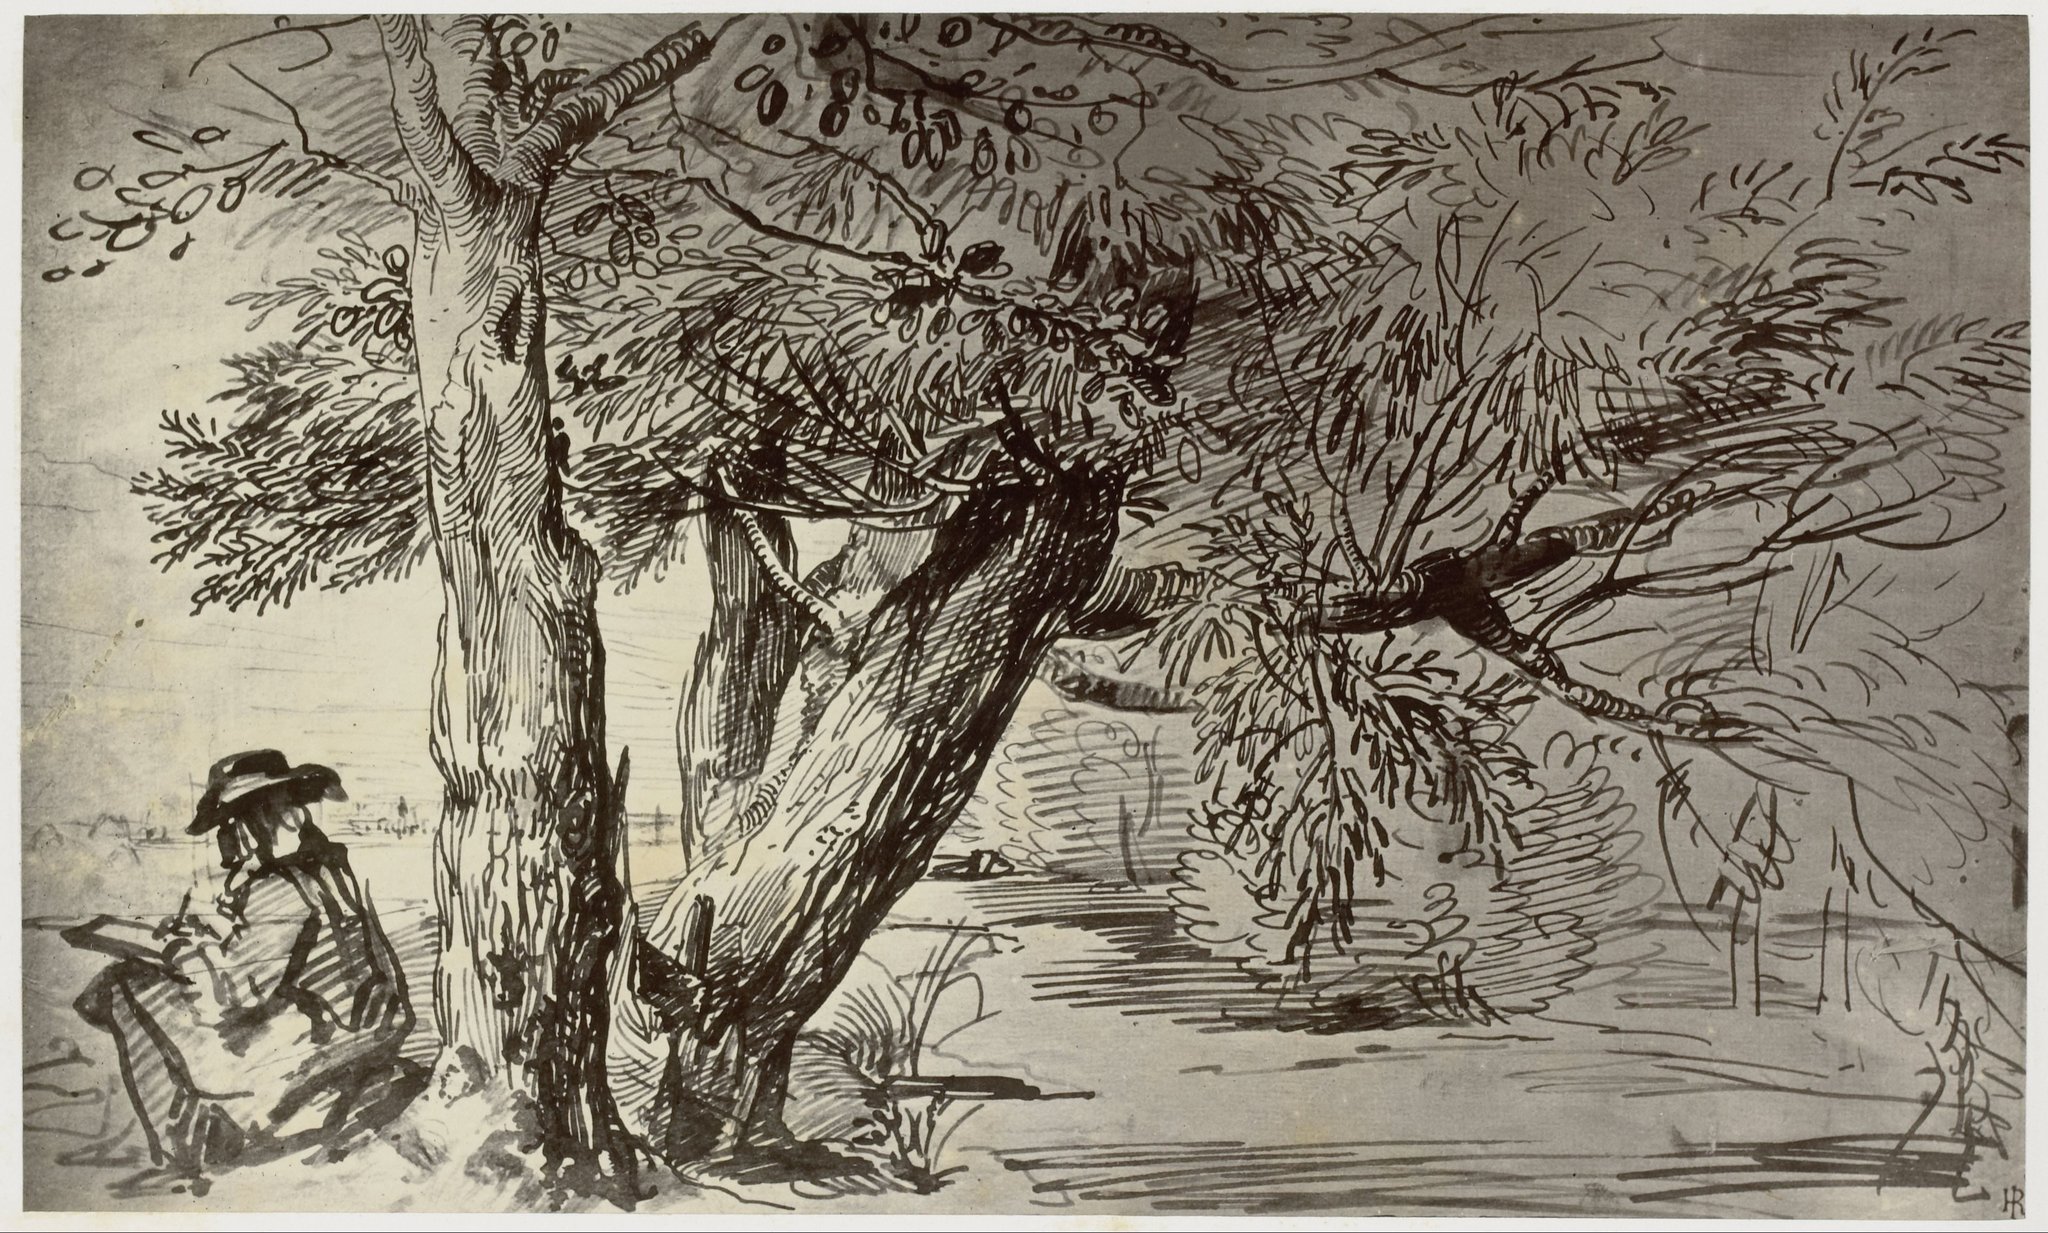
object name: photograph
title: Jan Lievens, A Landscape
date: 1855-1858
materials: cardboard, paper, photographic support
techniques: albumen print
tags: drawing, sketch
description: Fotoreproductie van tekening in 'The Reveley Collection of Drawings at Brynygwin', afb. 22.